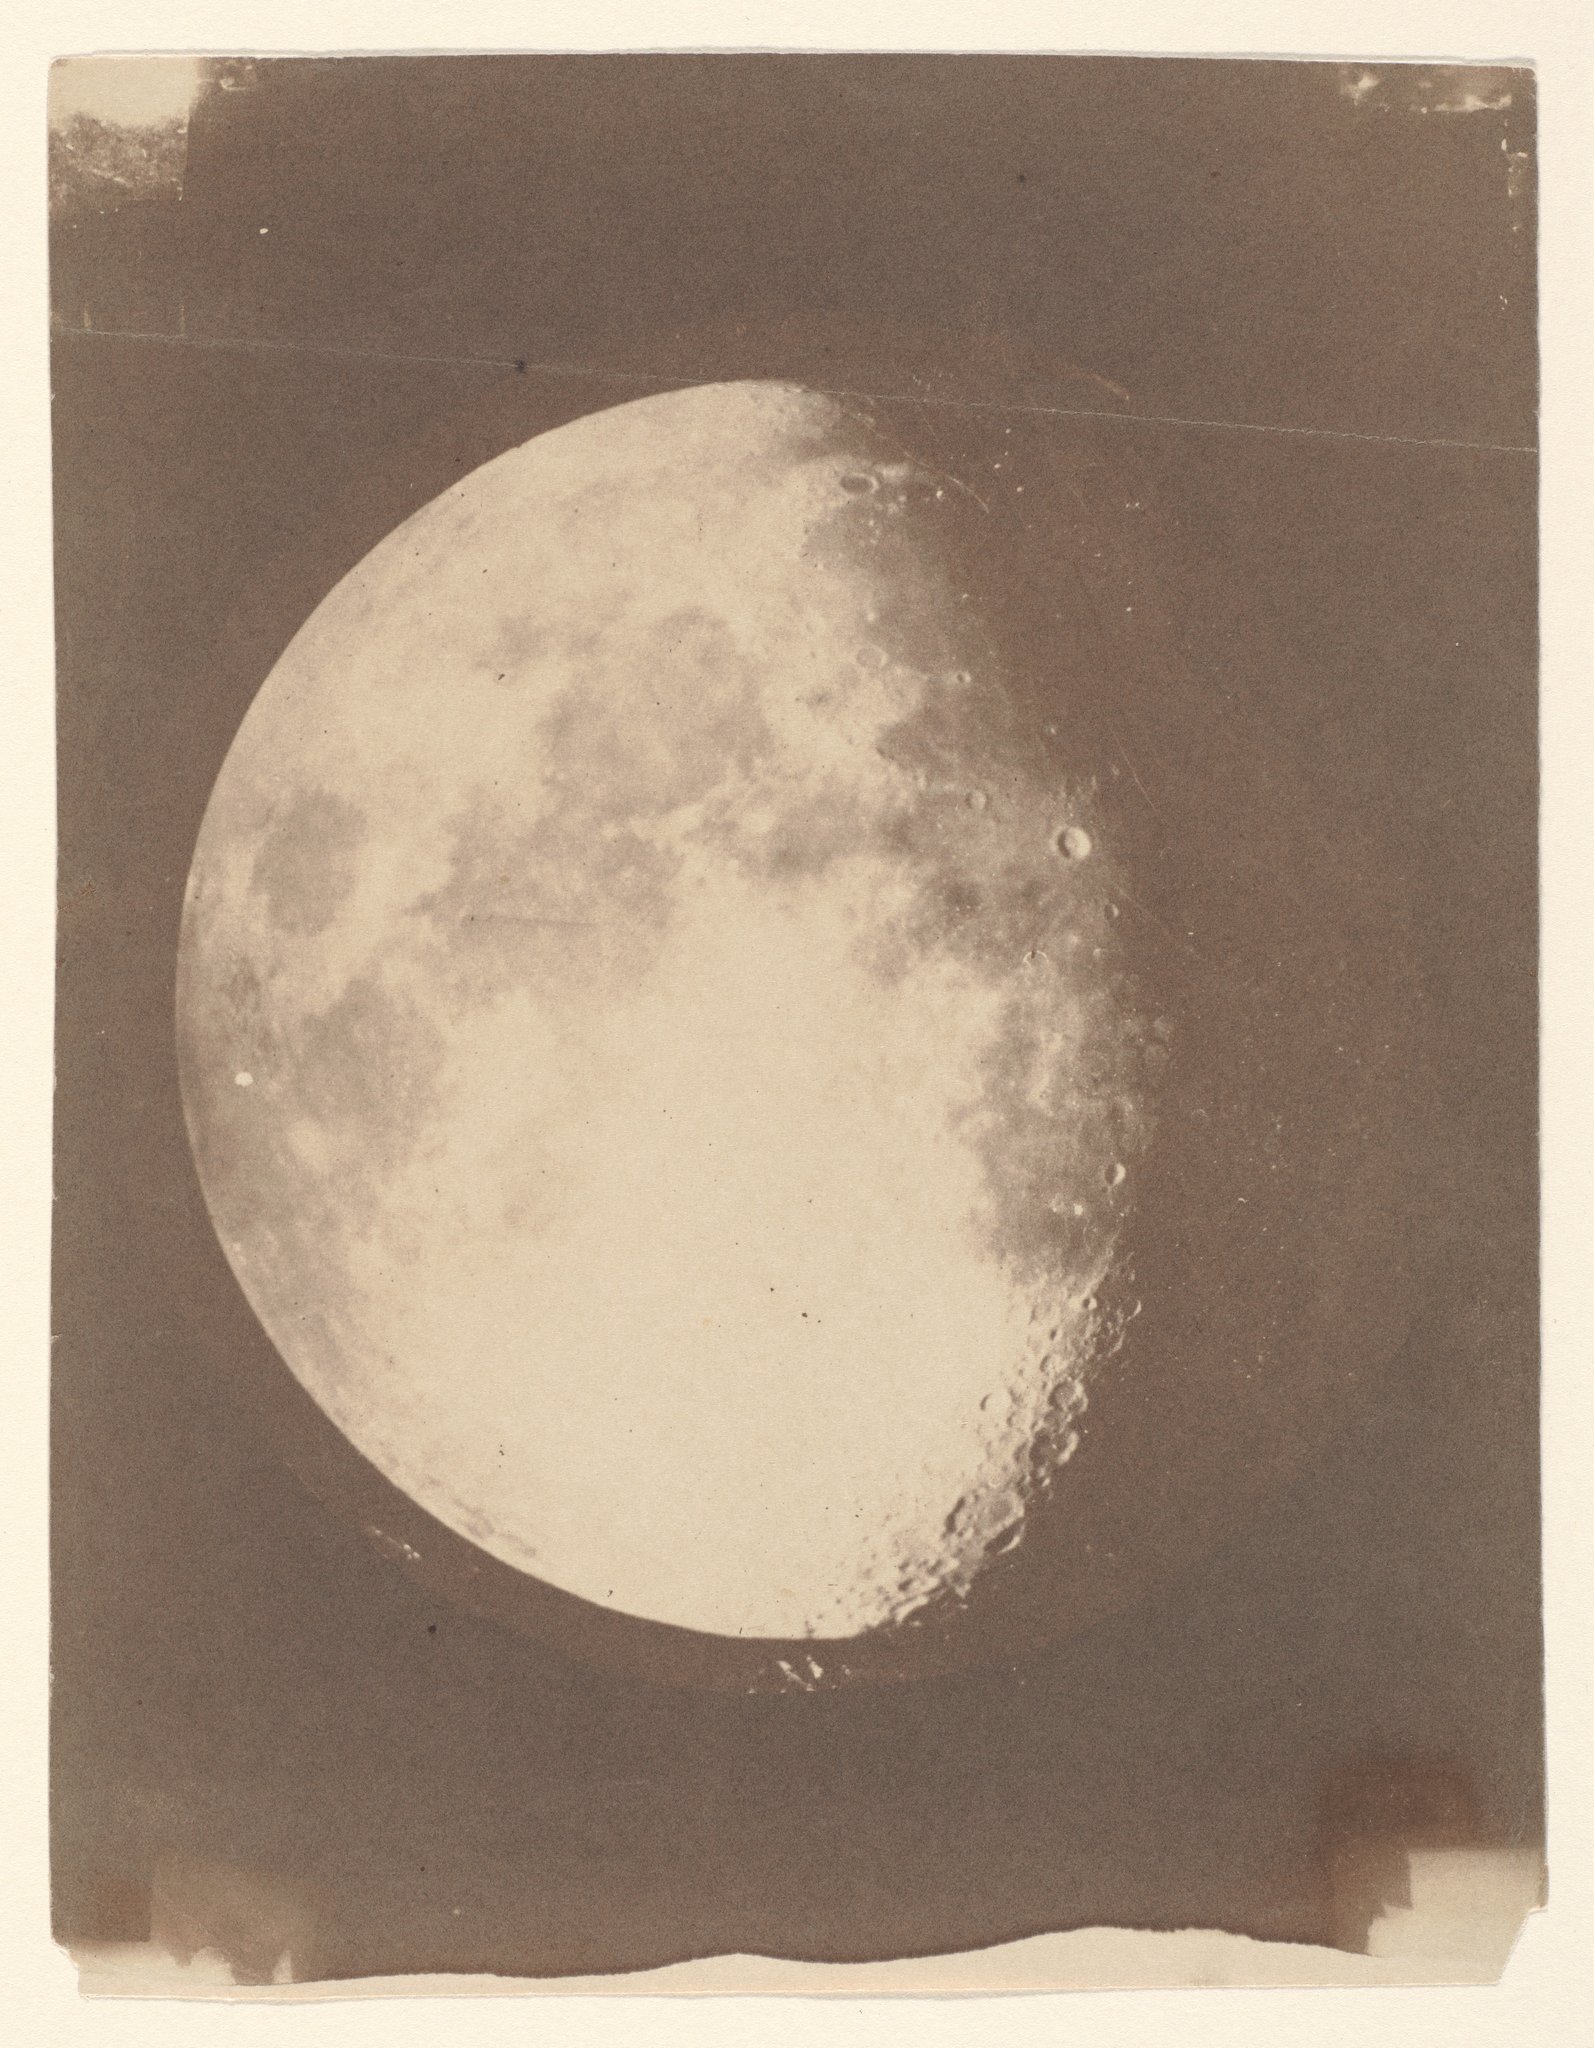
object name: photograph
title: The Moon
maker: john adams whipple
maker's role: artist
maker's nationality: american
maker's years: 1822-1891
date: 1857-1860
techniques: glass negative, salted paper print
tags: moon,astronomy